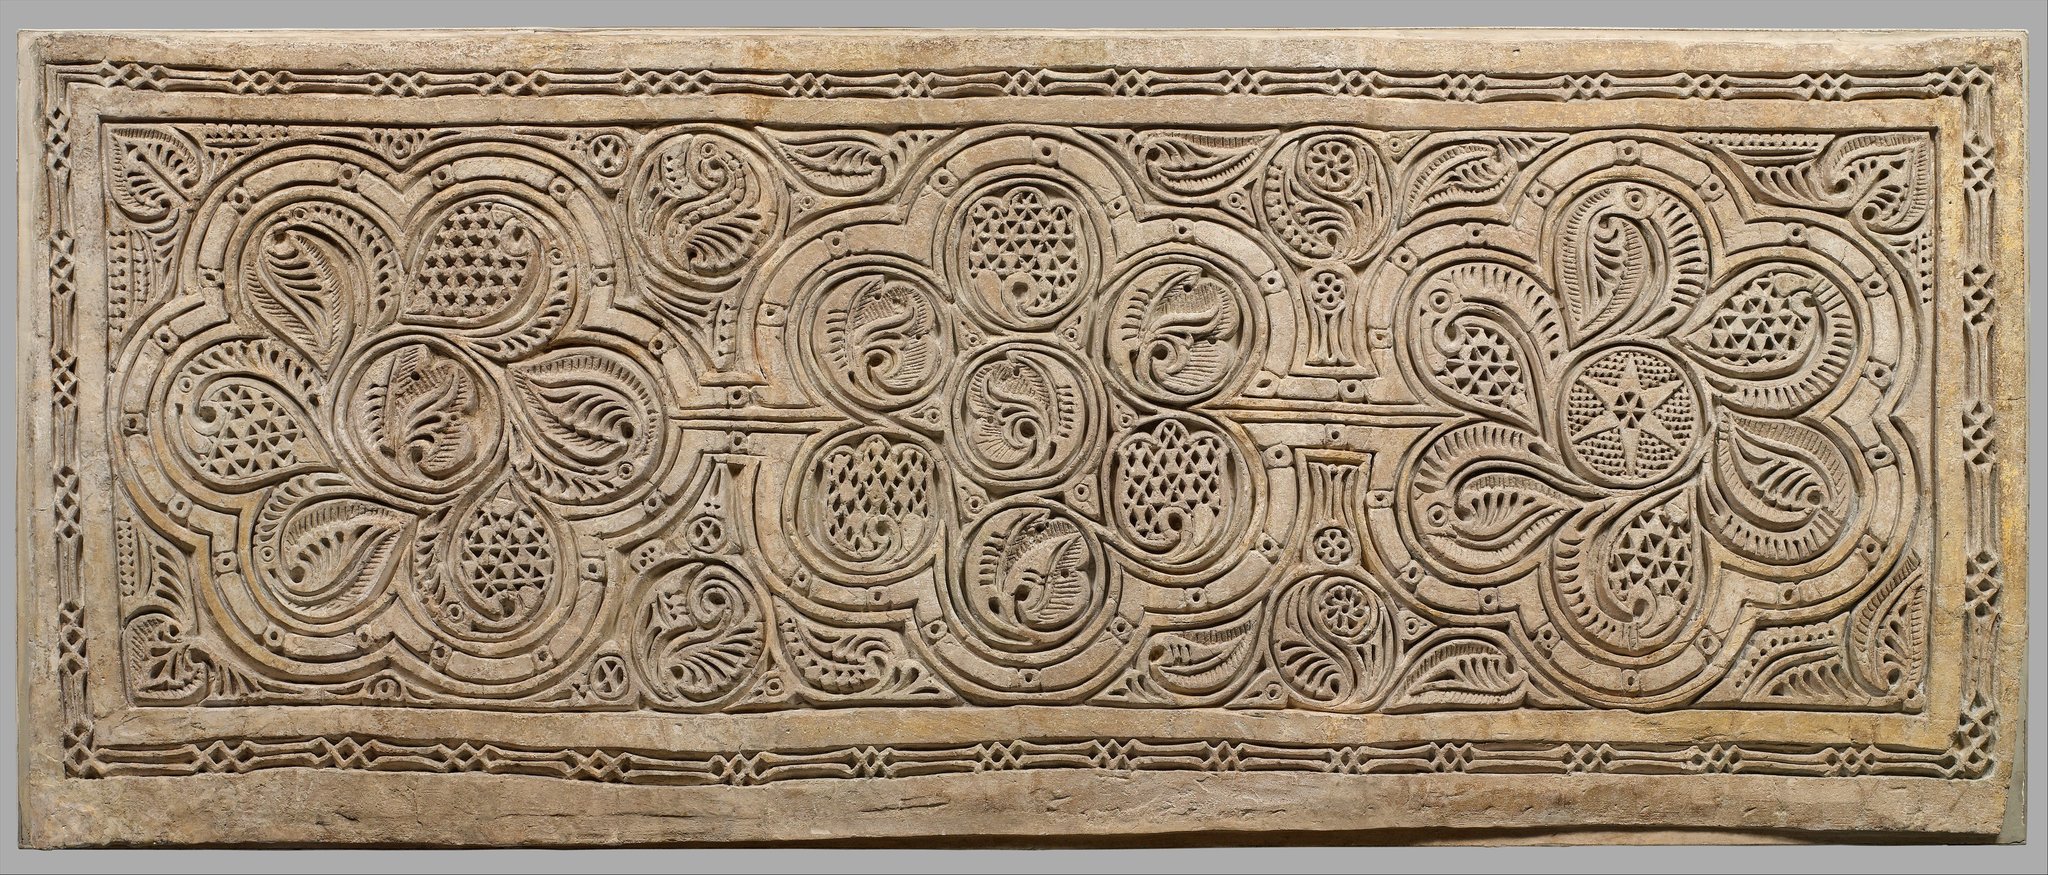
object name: dado panel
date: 901-1000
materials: plaster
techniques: carving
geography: iran